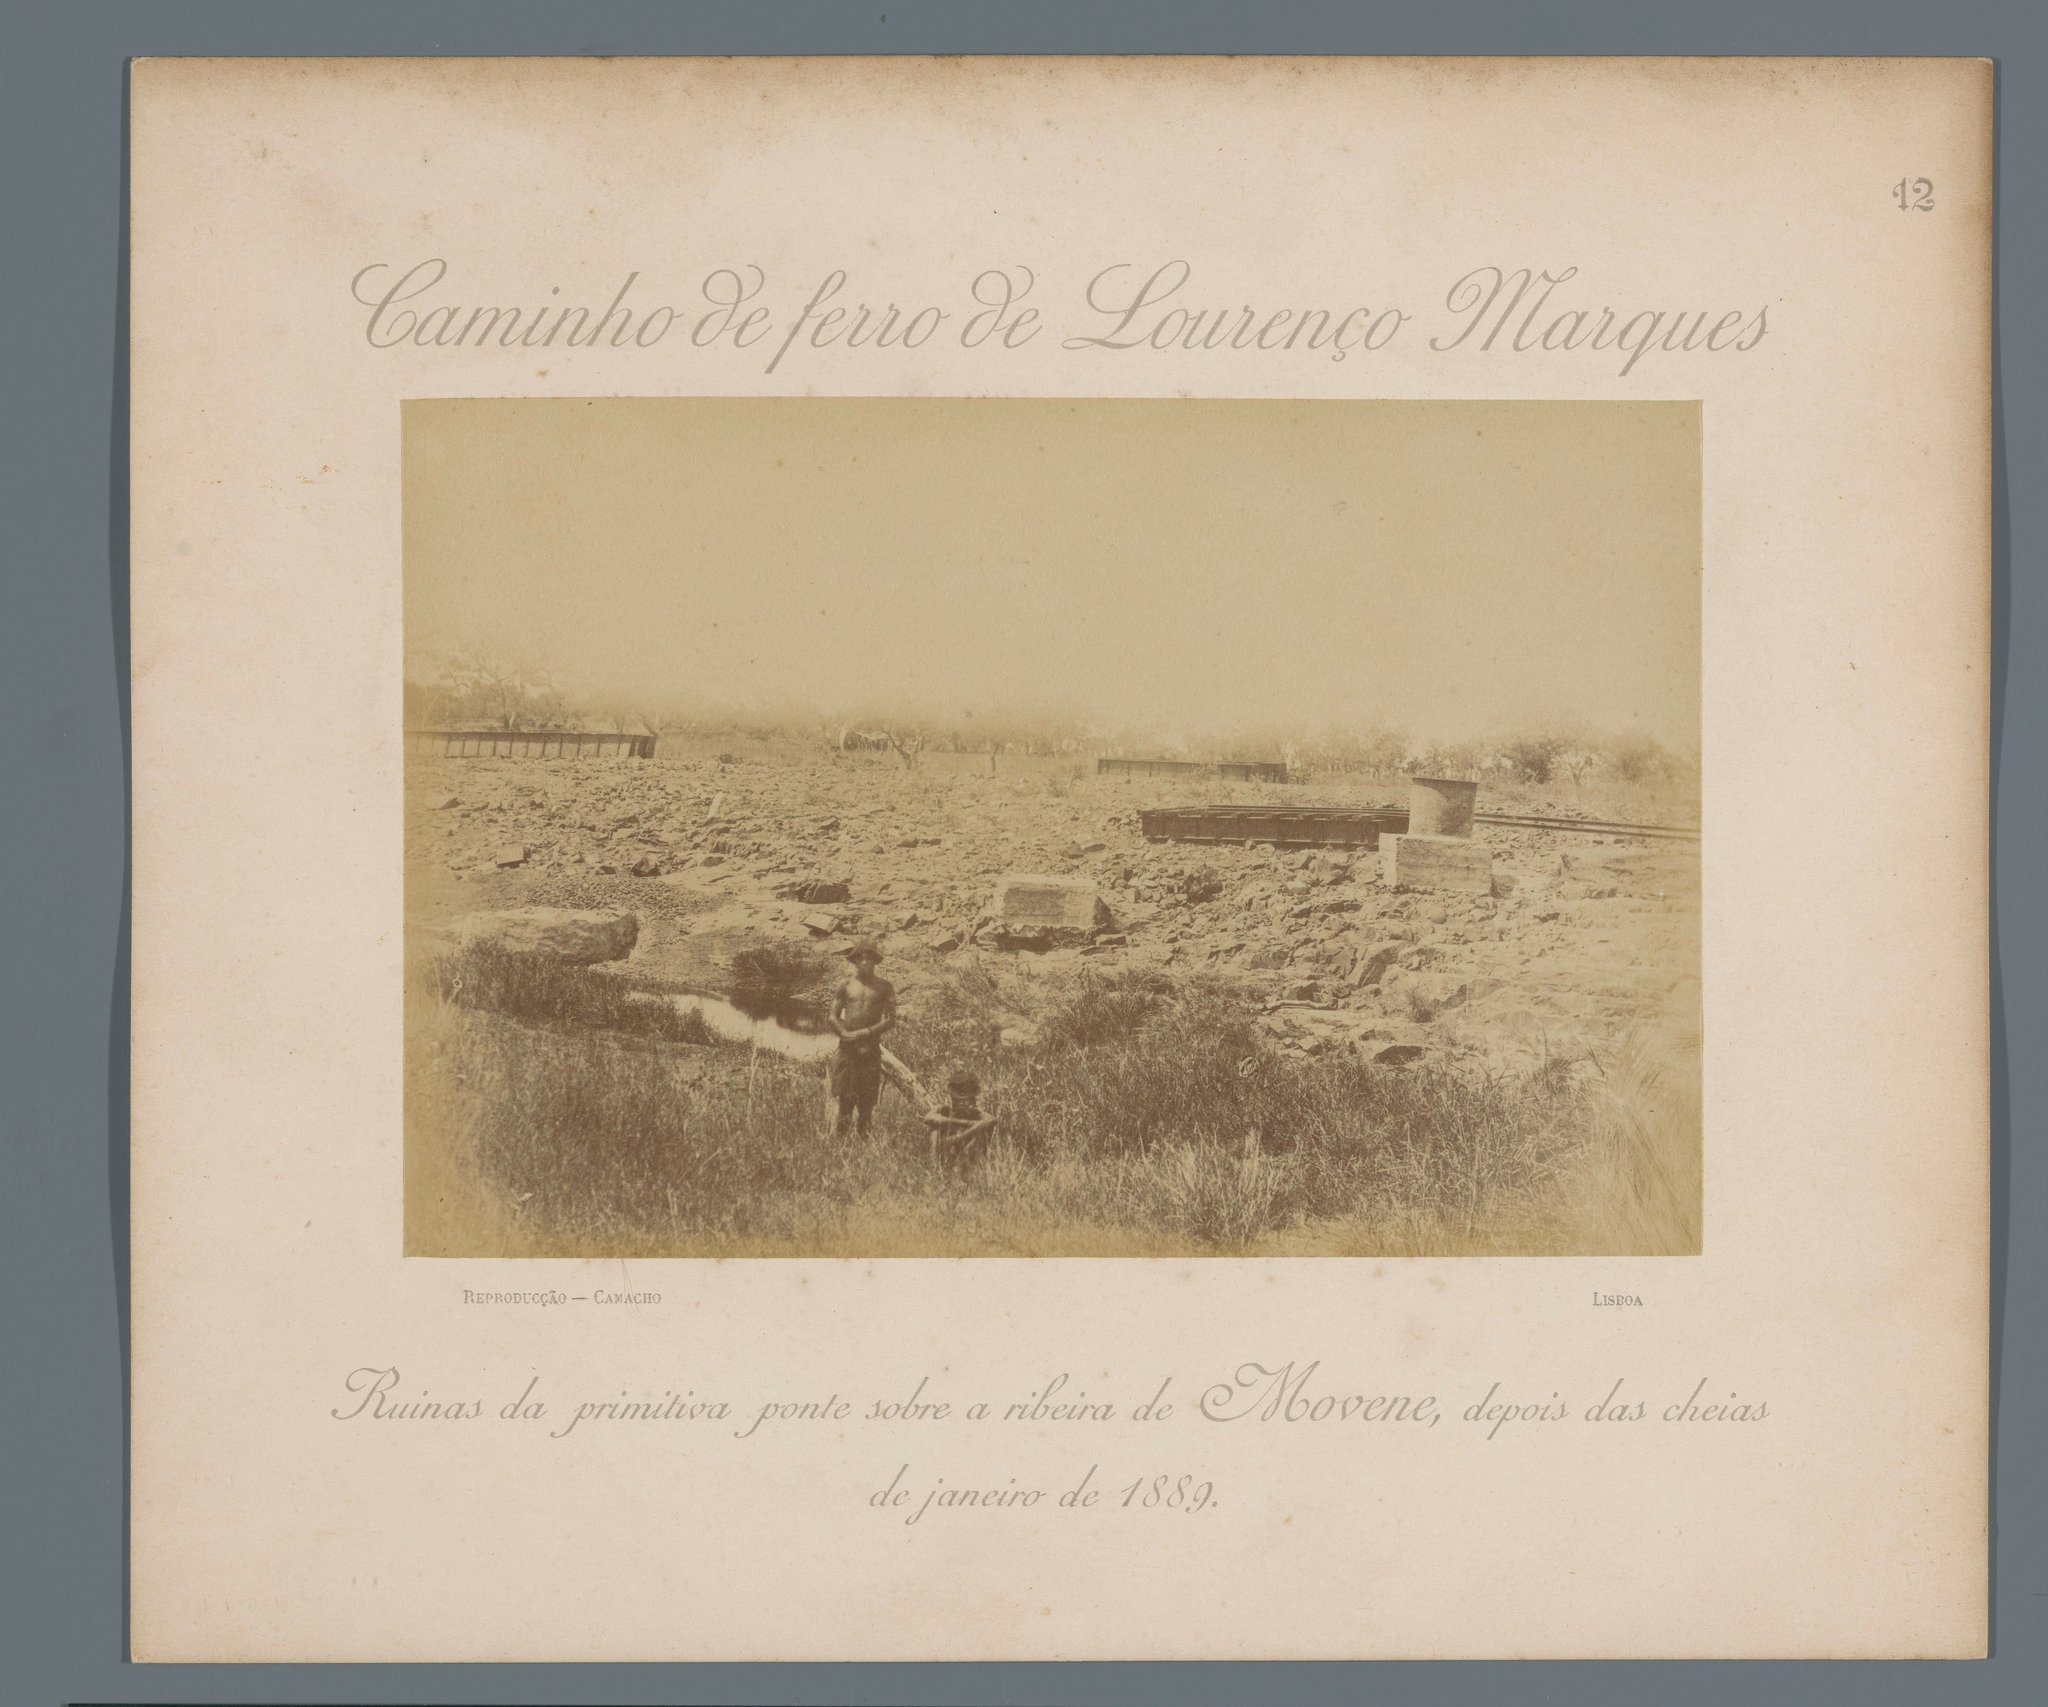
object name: photograph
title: Resten van een brug over de Rio Movene in Mozambique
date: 1889-1895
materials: photographic support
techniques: albumen print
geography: lisbon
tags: bridges by construction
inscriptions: number: ‘12’